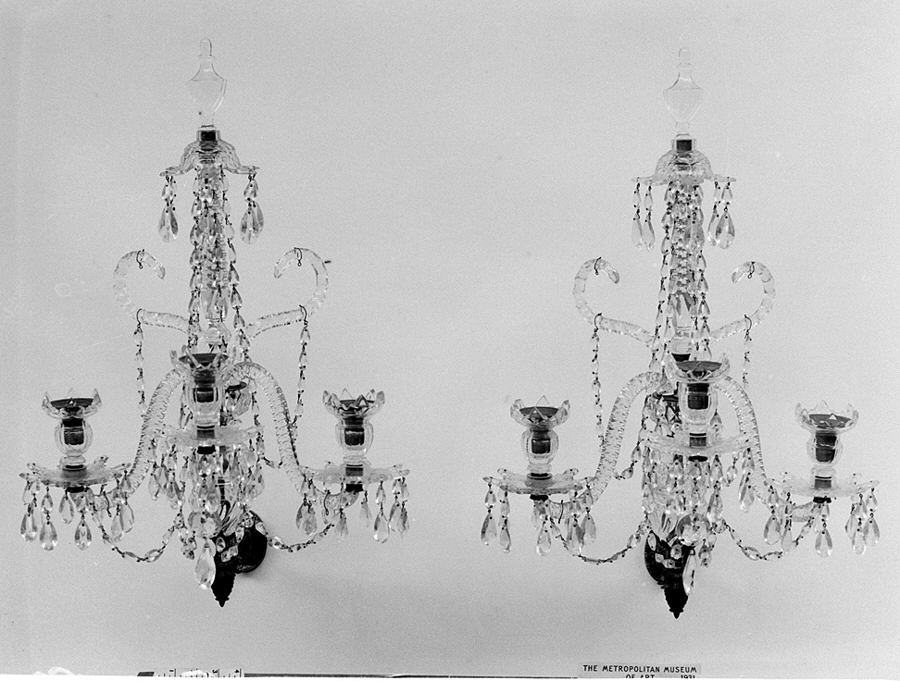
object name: sconce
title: Pair of sconces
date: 1780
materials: gilt bronze, glass